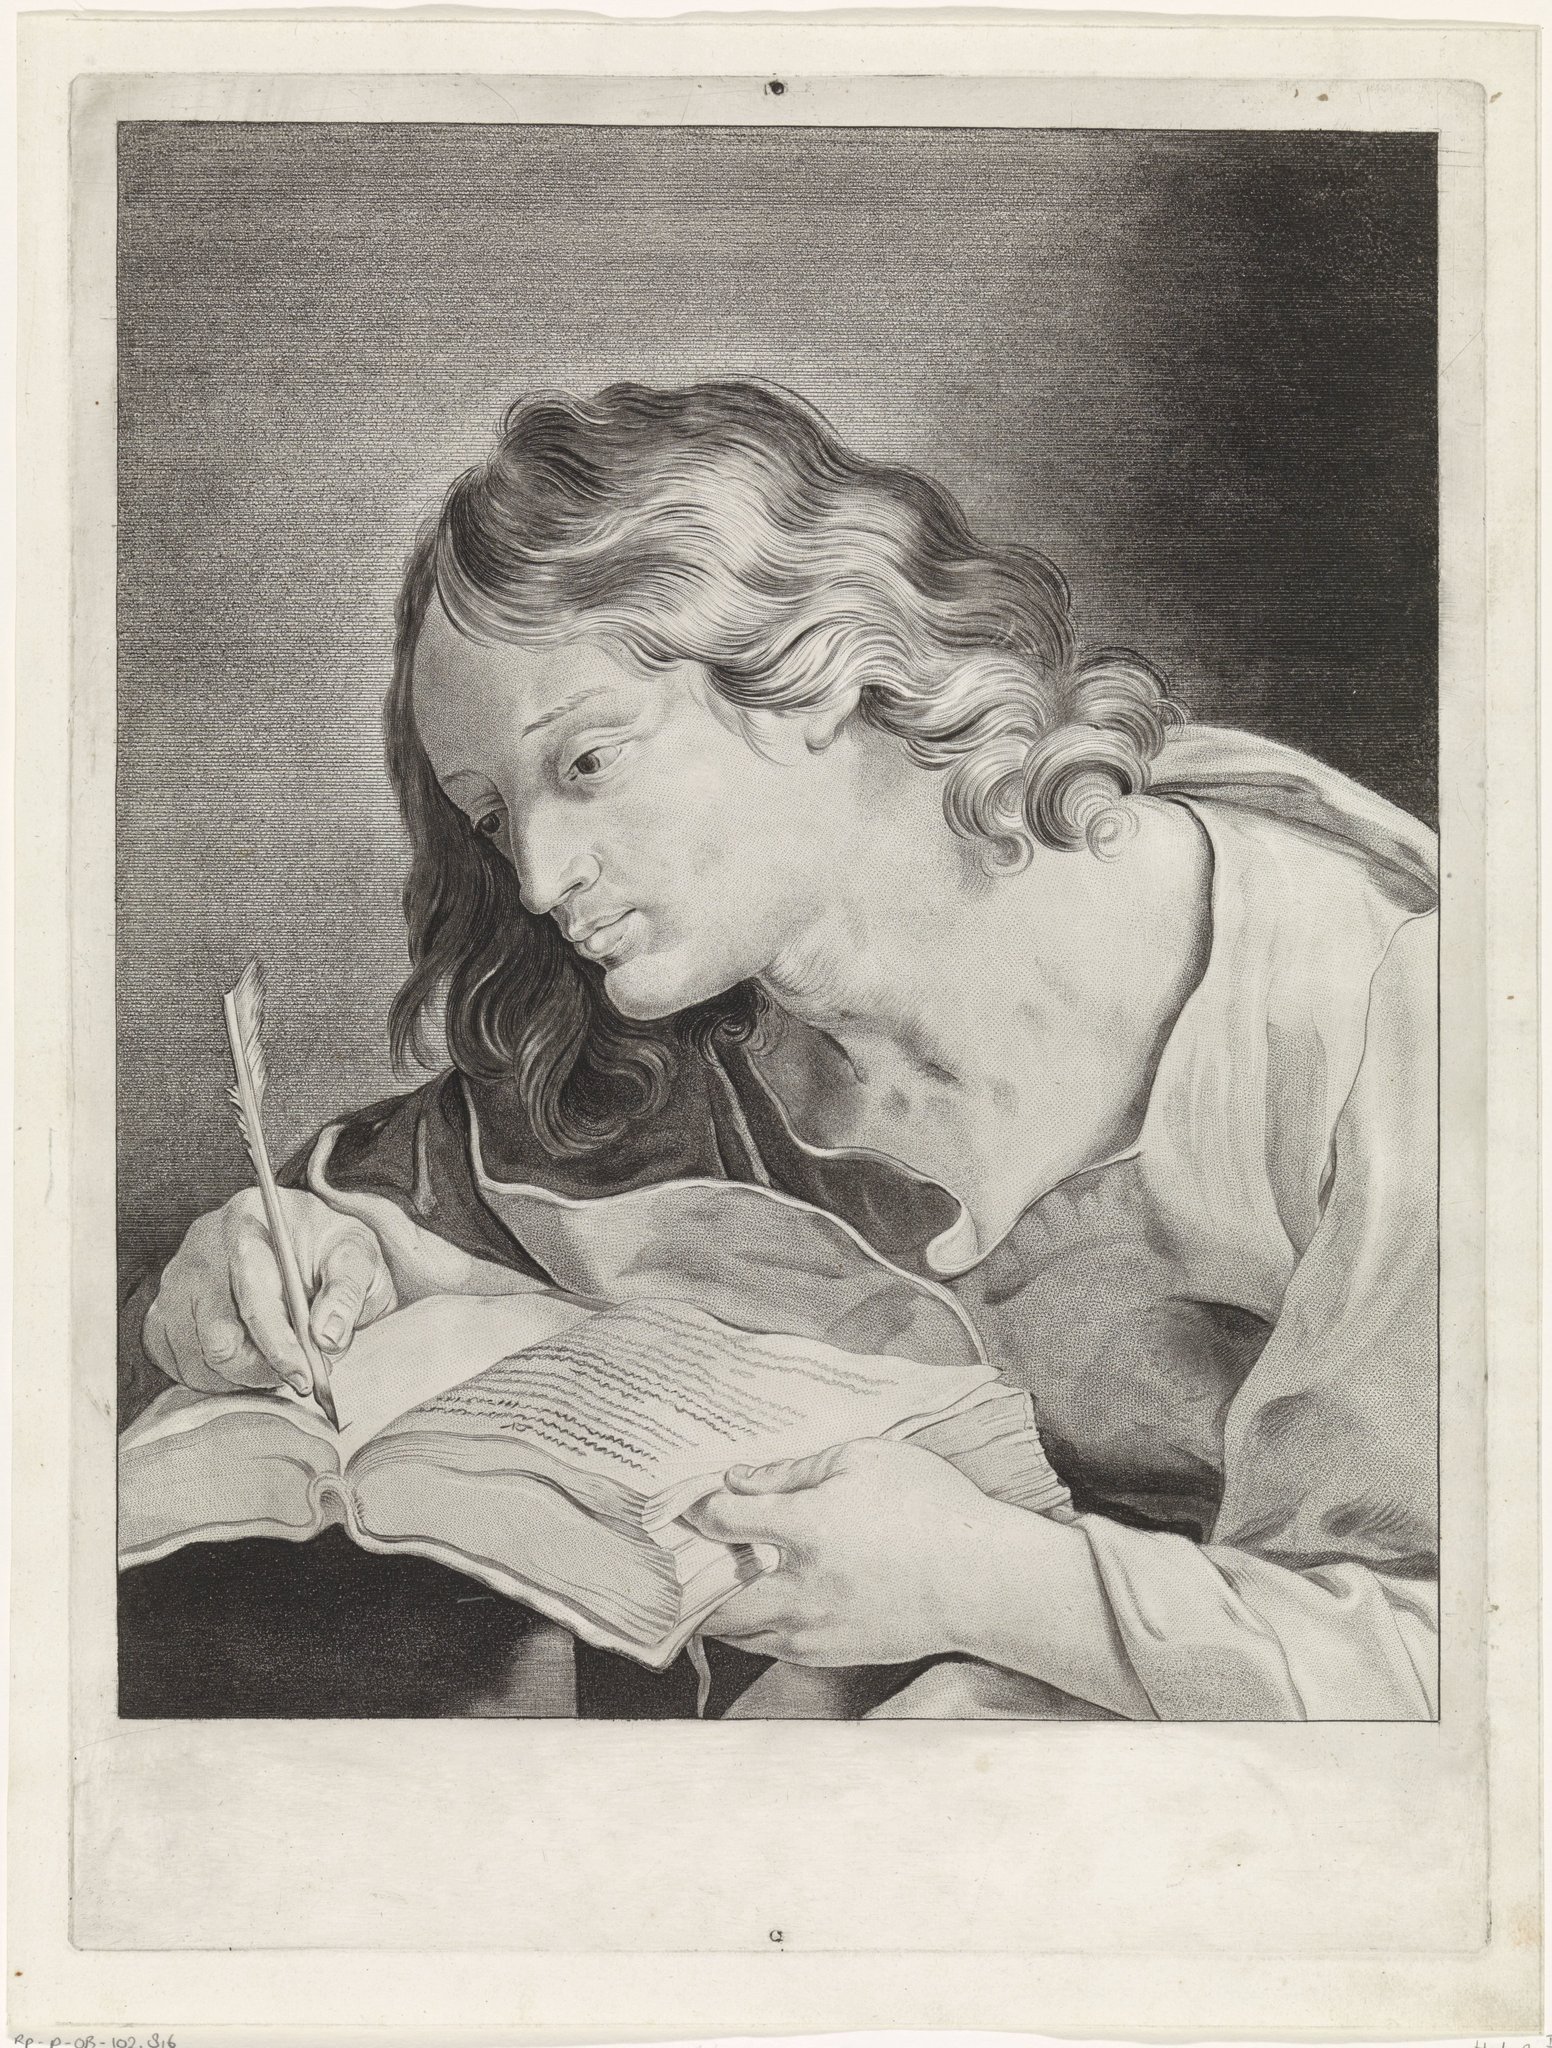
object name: book illustration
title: De Engel des Heeren verschynt Mozes in den braambosch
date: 1711-1720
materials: paper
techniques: engraving, etching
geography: amsterdam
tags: a burning bush attracts moses' attention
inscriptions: collector's mark: Lugt 2228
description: God verschijnt voor Mozes in de gedaante van een engel in een brandende braamstruik. Hij vertelt Mozes dat hij is voorbestemd om de Israëlieten te verlossen uit de handen van de Egyptenaren. Illustratie voor het Oude Testament, Exod. 3: 2-10. Onder de voorstelling een titel in het Hebreeuws, Engels, Duits, Latijn, Frans en Nederlands.